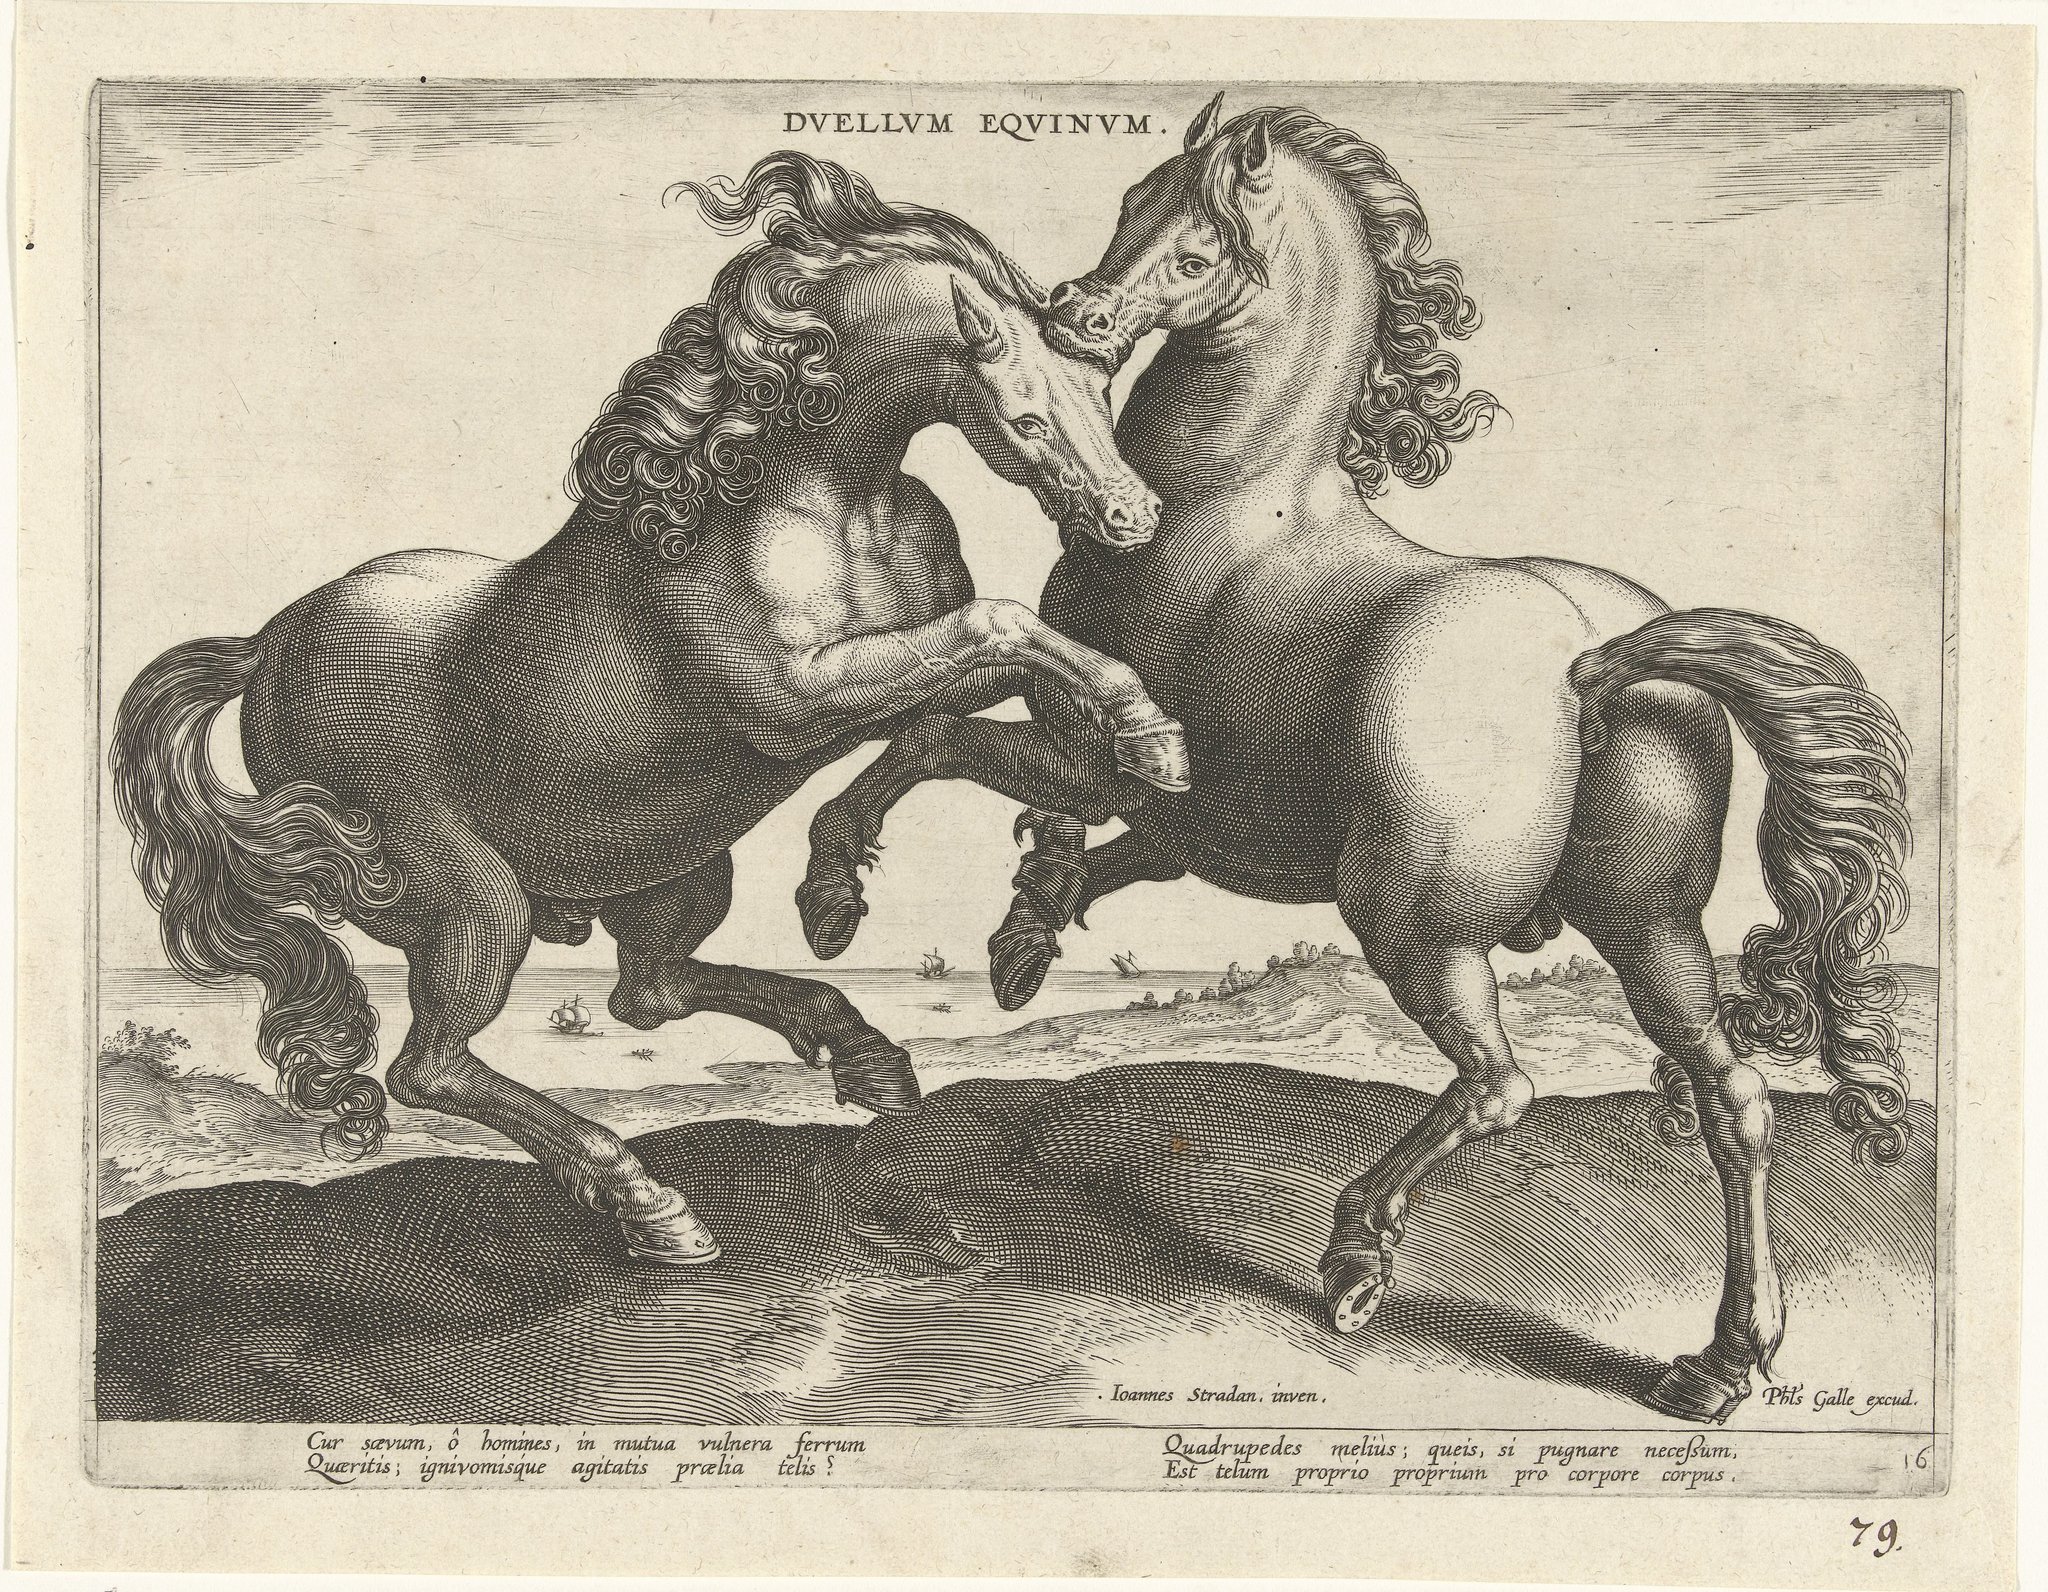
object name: print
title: Dvellvm Eqvinvm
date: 1583-1587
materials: paper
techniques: engraving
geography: antwerp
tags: don juan van oostenrijk, fighting horses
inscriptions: number: ‘79’, collector's mark: Lugt 2228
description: Twee paarden vechten. Een van de paarden bijt de andere in het oor. De prent heeft een Latijns onderschrift en maakt deel uit van het eerste deel van een 39-delige serie over de paardenrassen uit Koninklijke stallen van Don Juan van Oostenrijk.